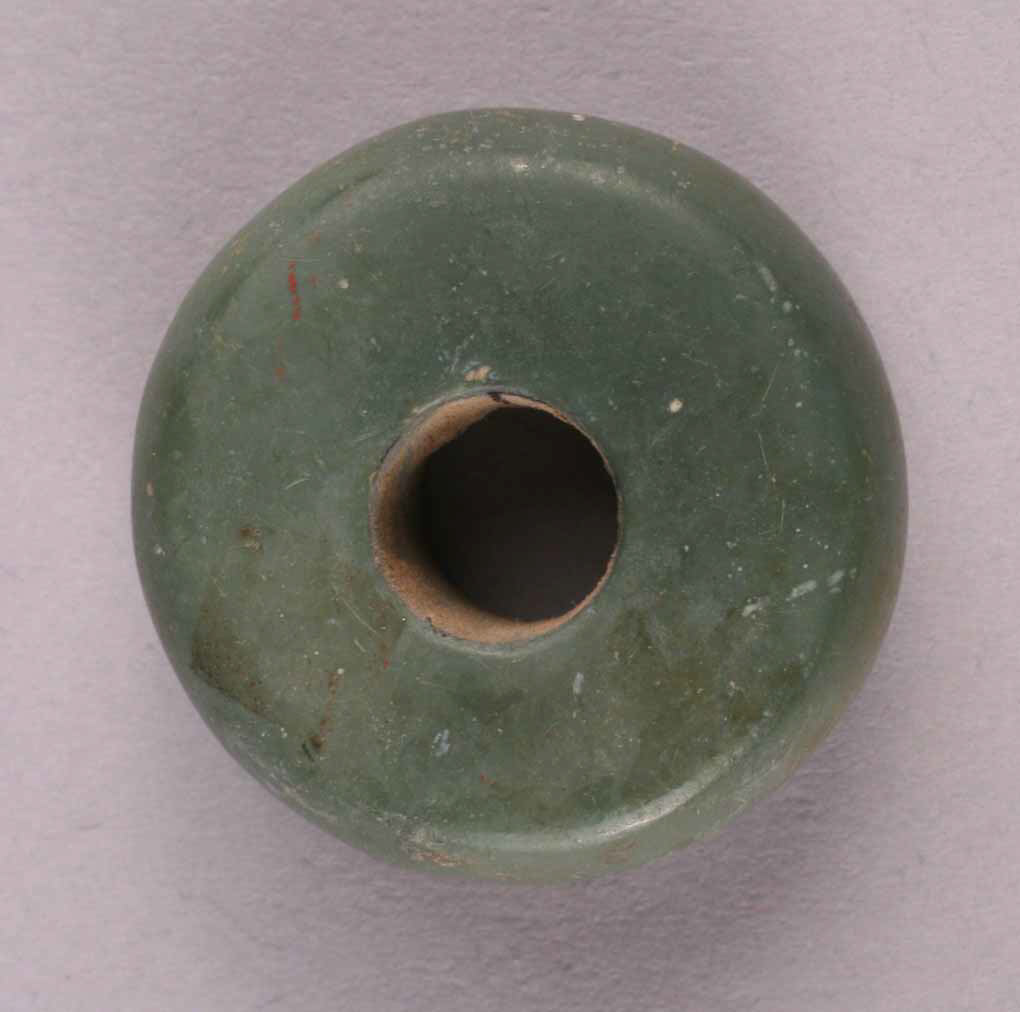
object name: bead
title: Beads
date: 701-1300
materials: stone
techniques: cutting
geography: iran